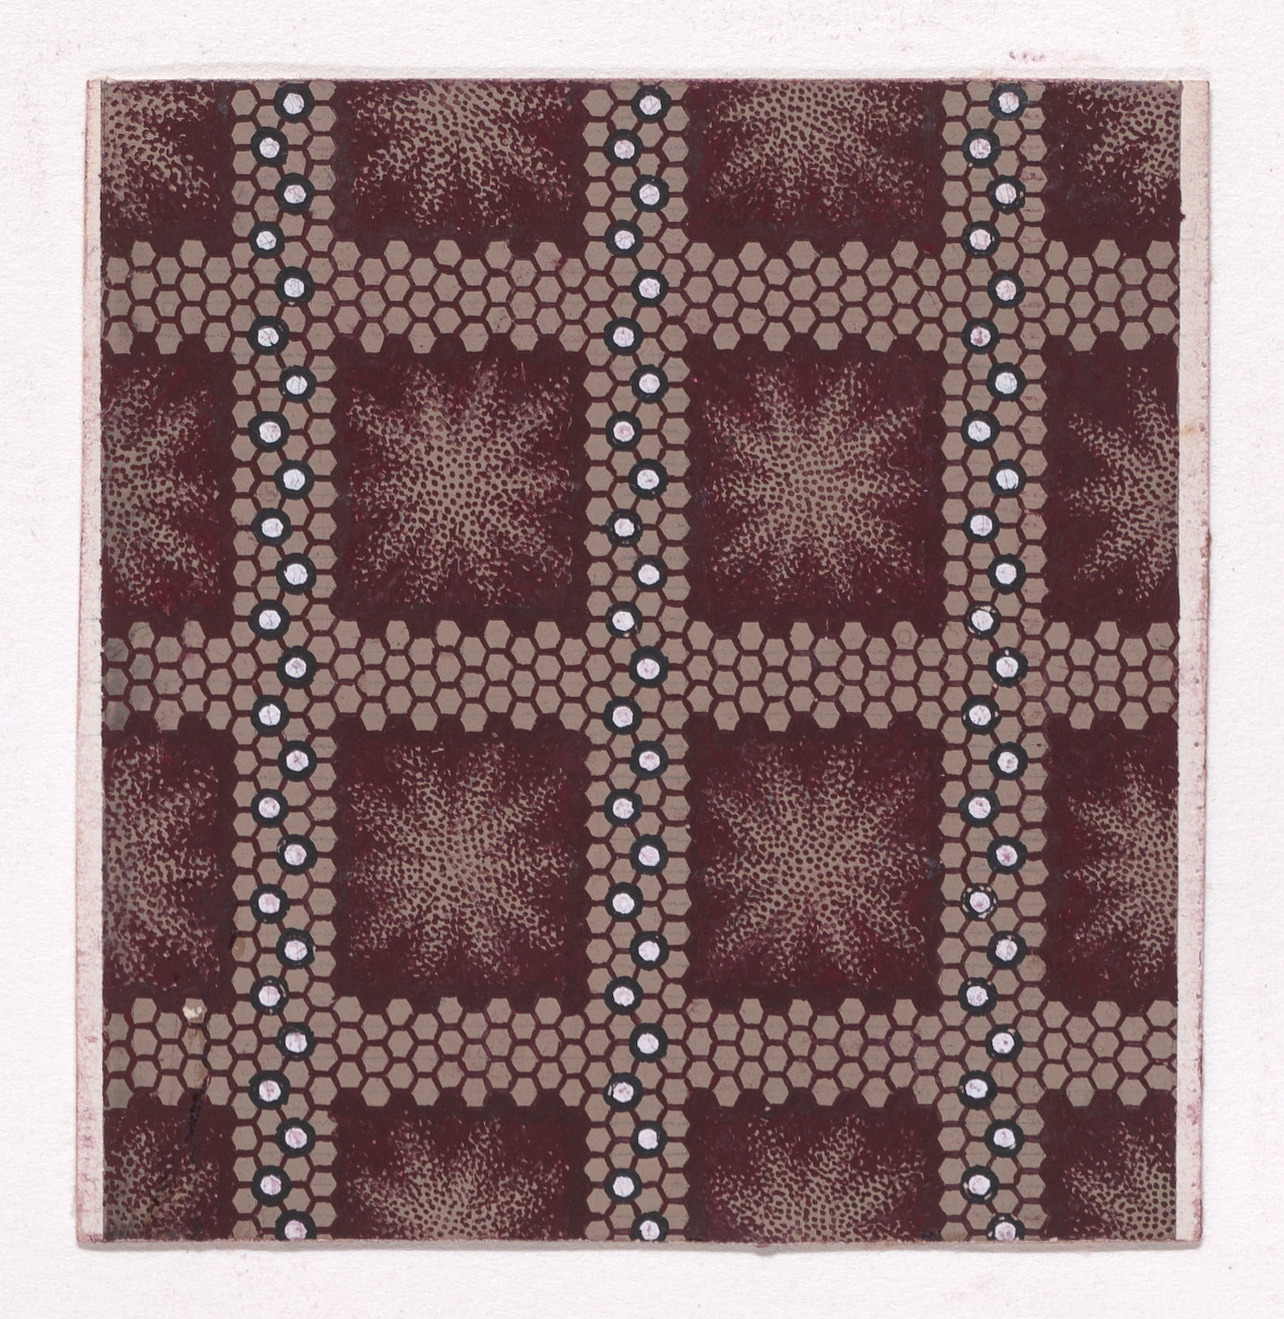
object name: drawing ornament architecture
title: Textile Design with a Checked Pattern of Intersecting Honeycomb Lines and Vertical Stripes of Pearls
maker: anonymous, alsatian, 19th century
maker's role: artist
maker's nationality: alsatian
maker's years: 1800-1900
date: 1840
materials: gouache